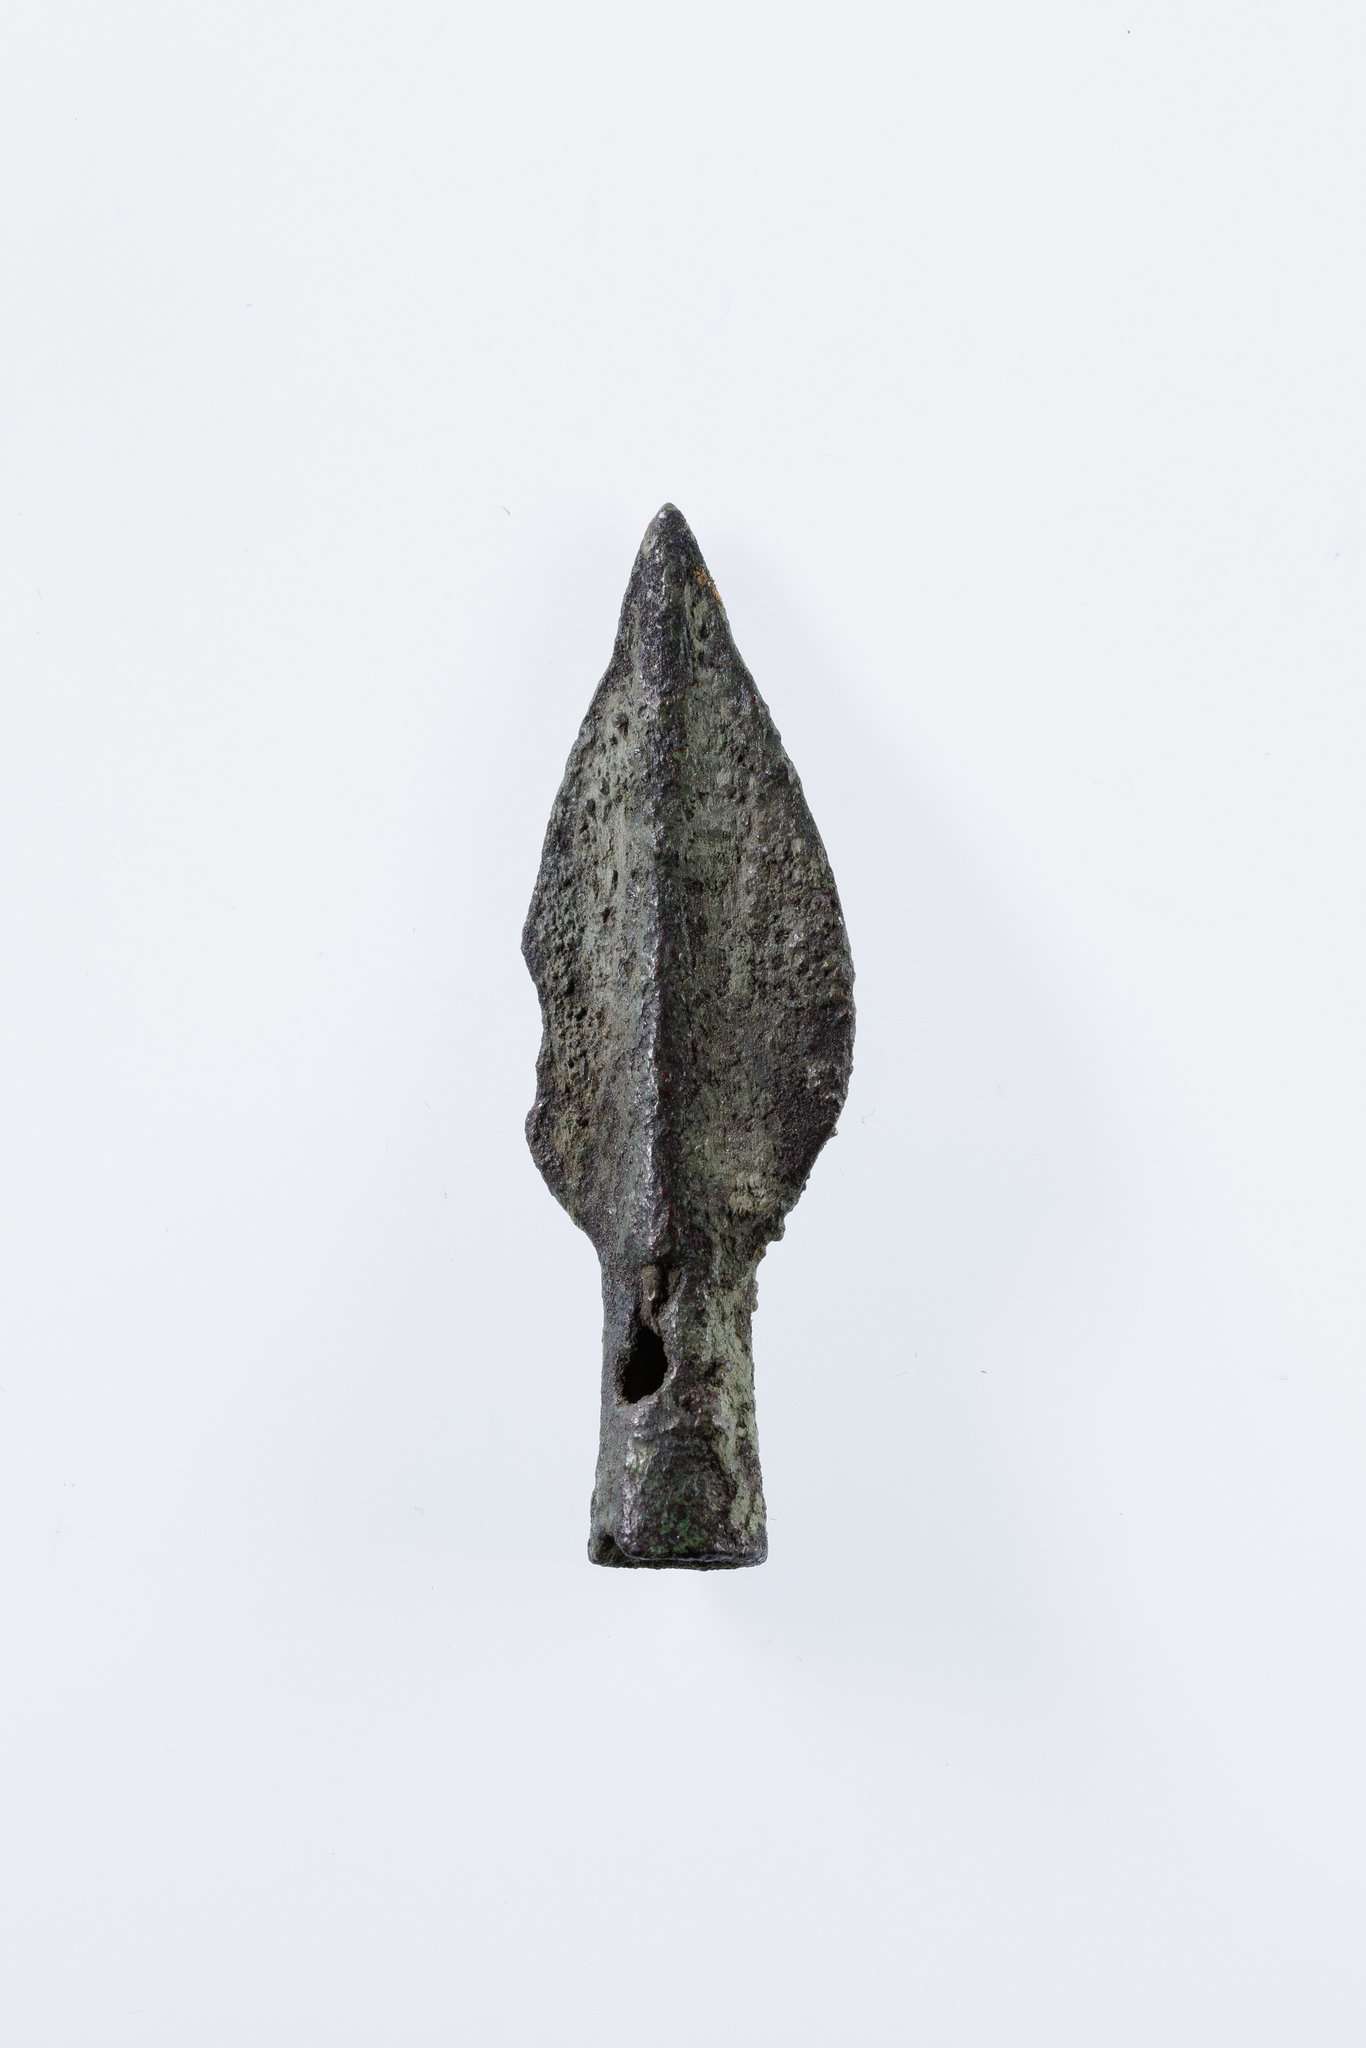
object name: arrow point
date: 664-525 BCE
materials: bronze, copper alloy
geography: egypt